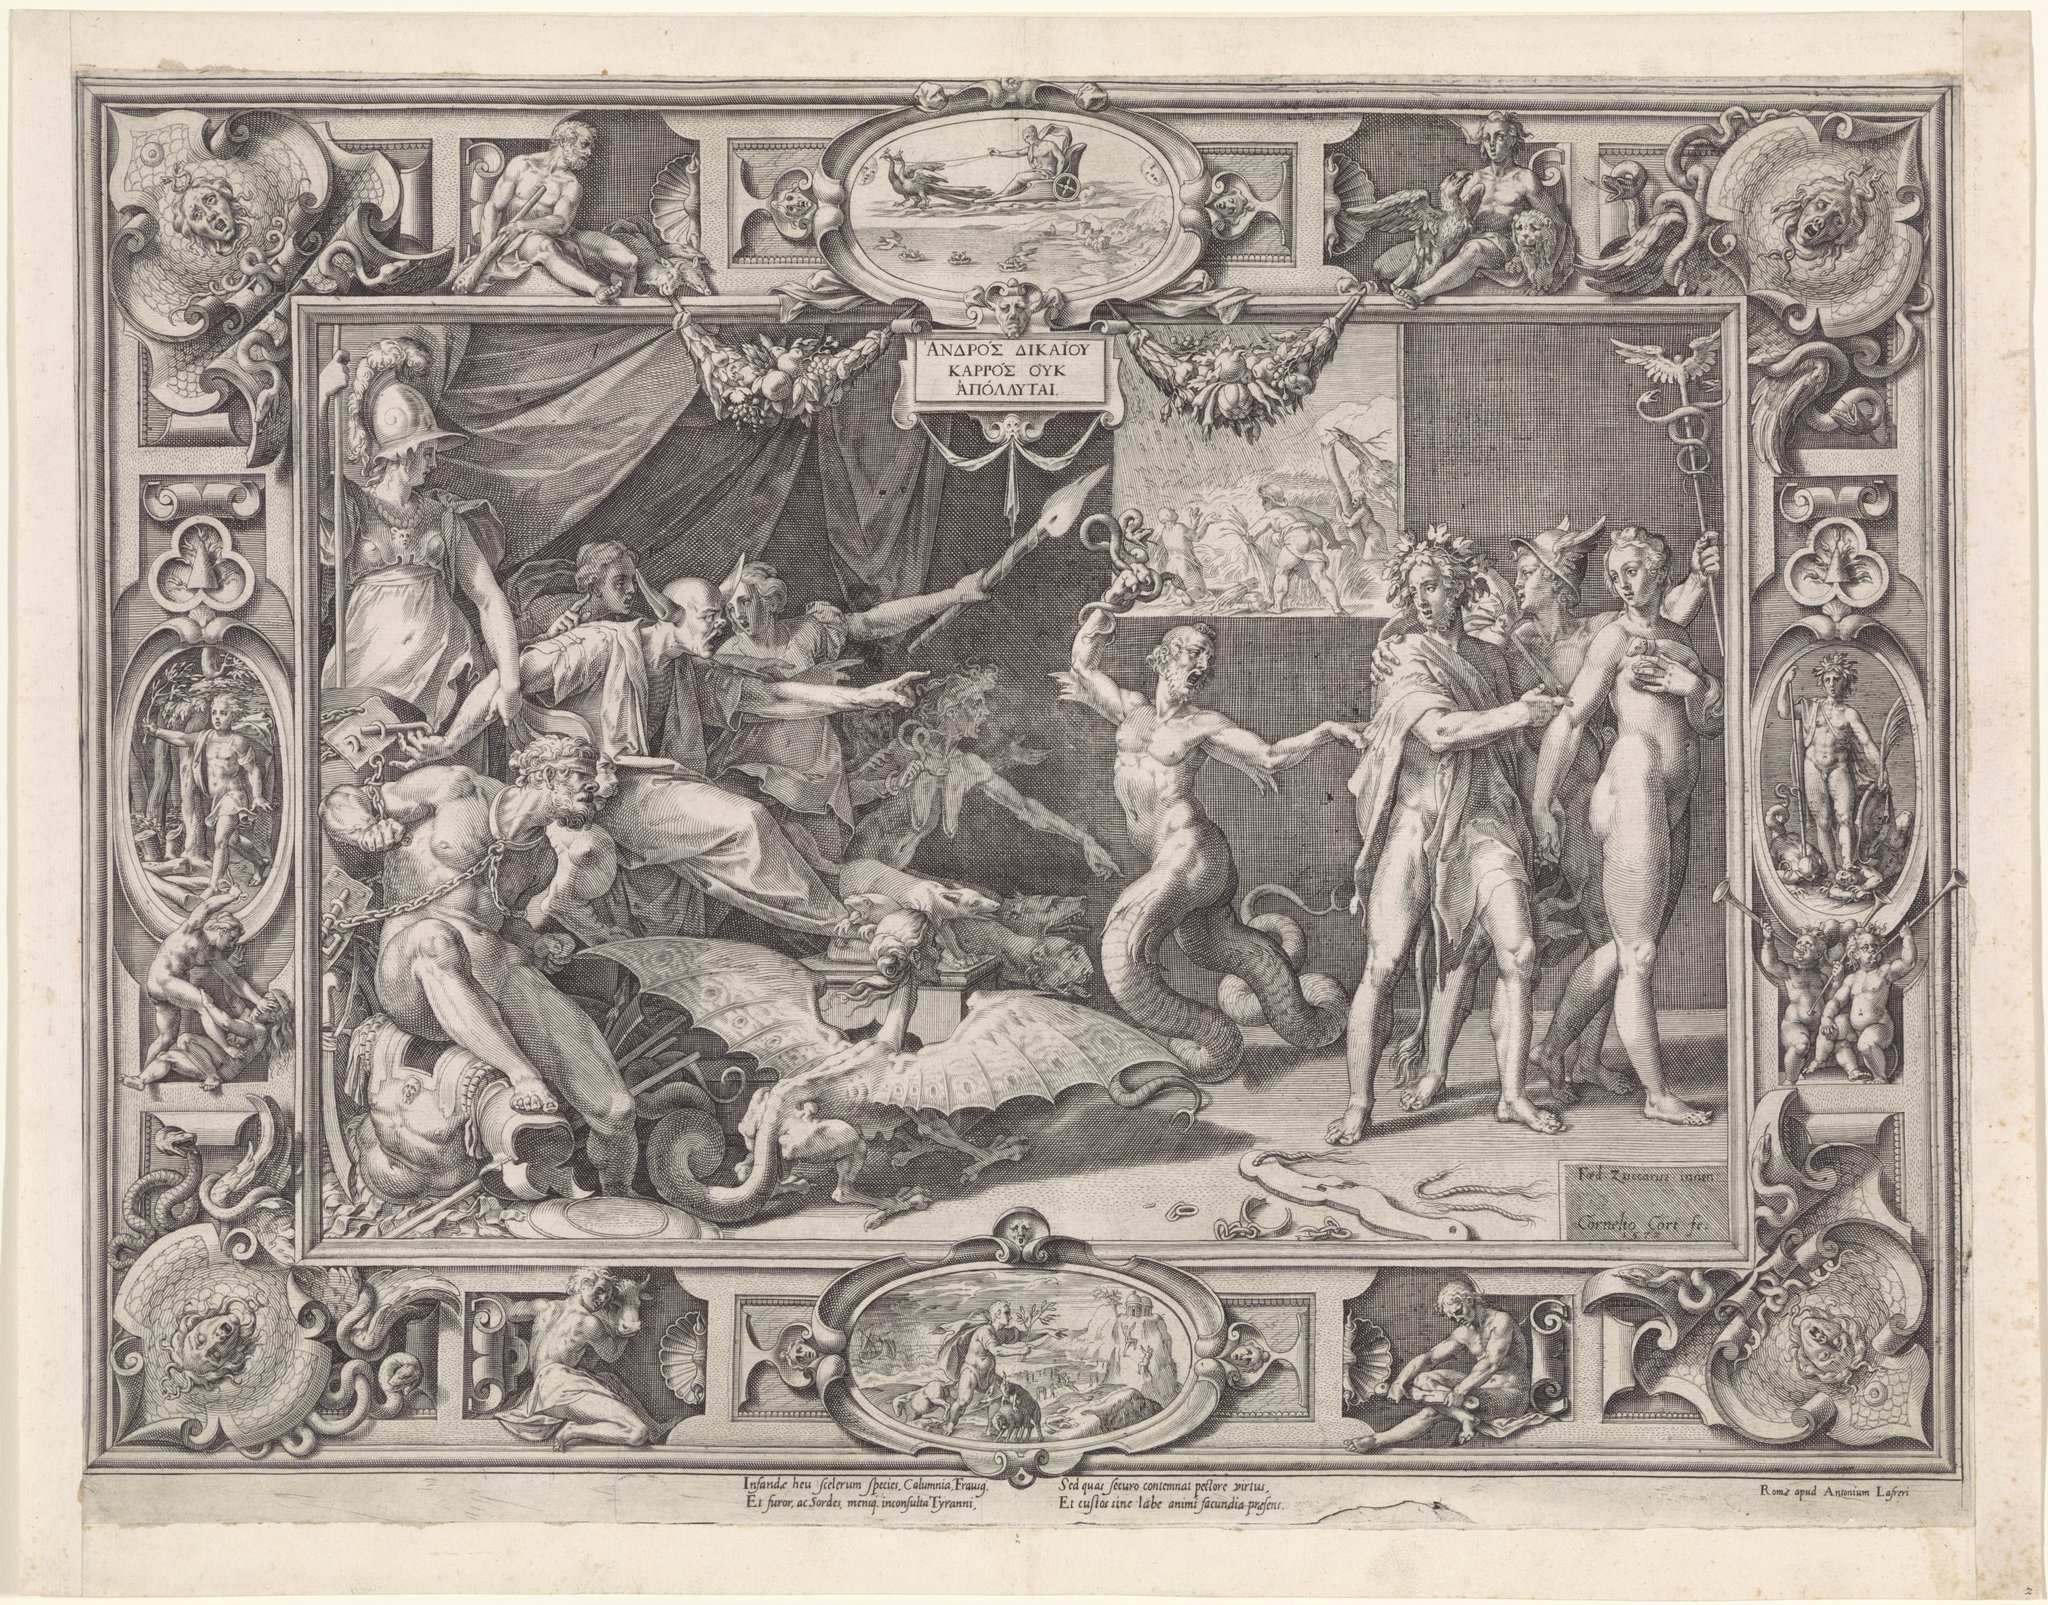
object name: print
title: Laster van Apelles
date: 1572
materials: paper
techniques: engraving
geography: rome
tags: calumny of apelles: bad judge with ass's ears on throne, with deceit, envy, ignorance, suspicion and treachery, confronted with innocent accused; remorse and truth present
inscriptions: collector's mark: Lugt 240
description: Links op een troon zit een koning wiens domheid wordt getoond door zijn ezelsoren. Zijn adviseurs zijn Laster, Bedrog, Afgunst en Woede. Achter de troon staat Minerva om hem tegen te houden. Rechts een kunstenaar die onder valse voorwendsels door de koning veroordeeld zou worden. Hij wordt vergezeld door de naakte Waarheid en de god Mercurius.